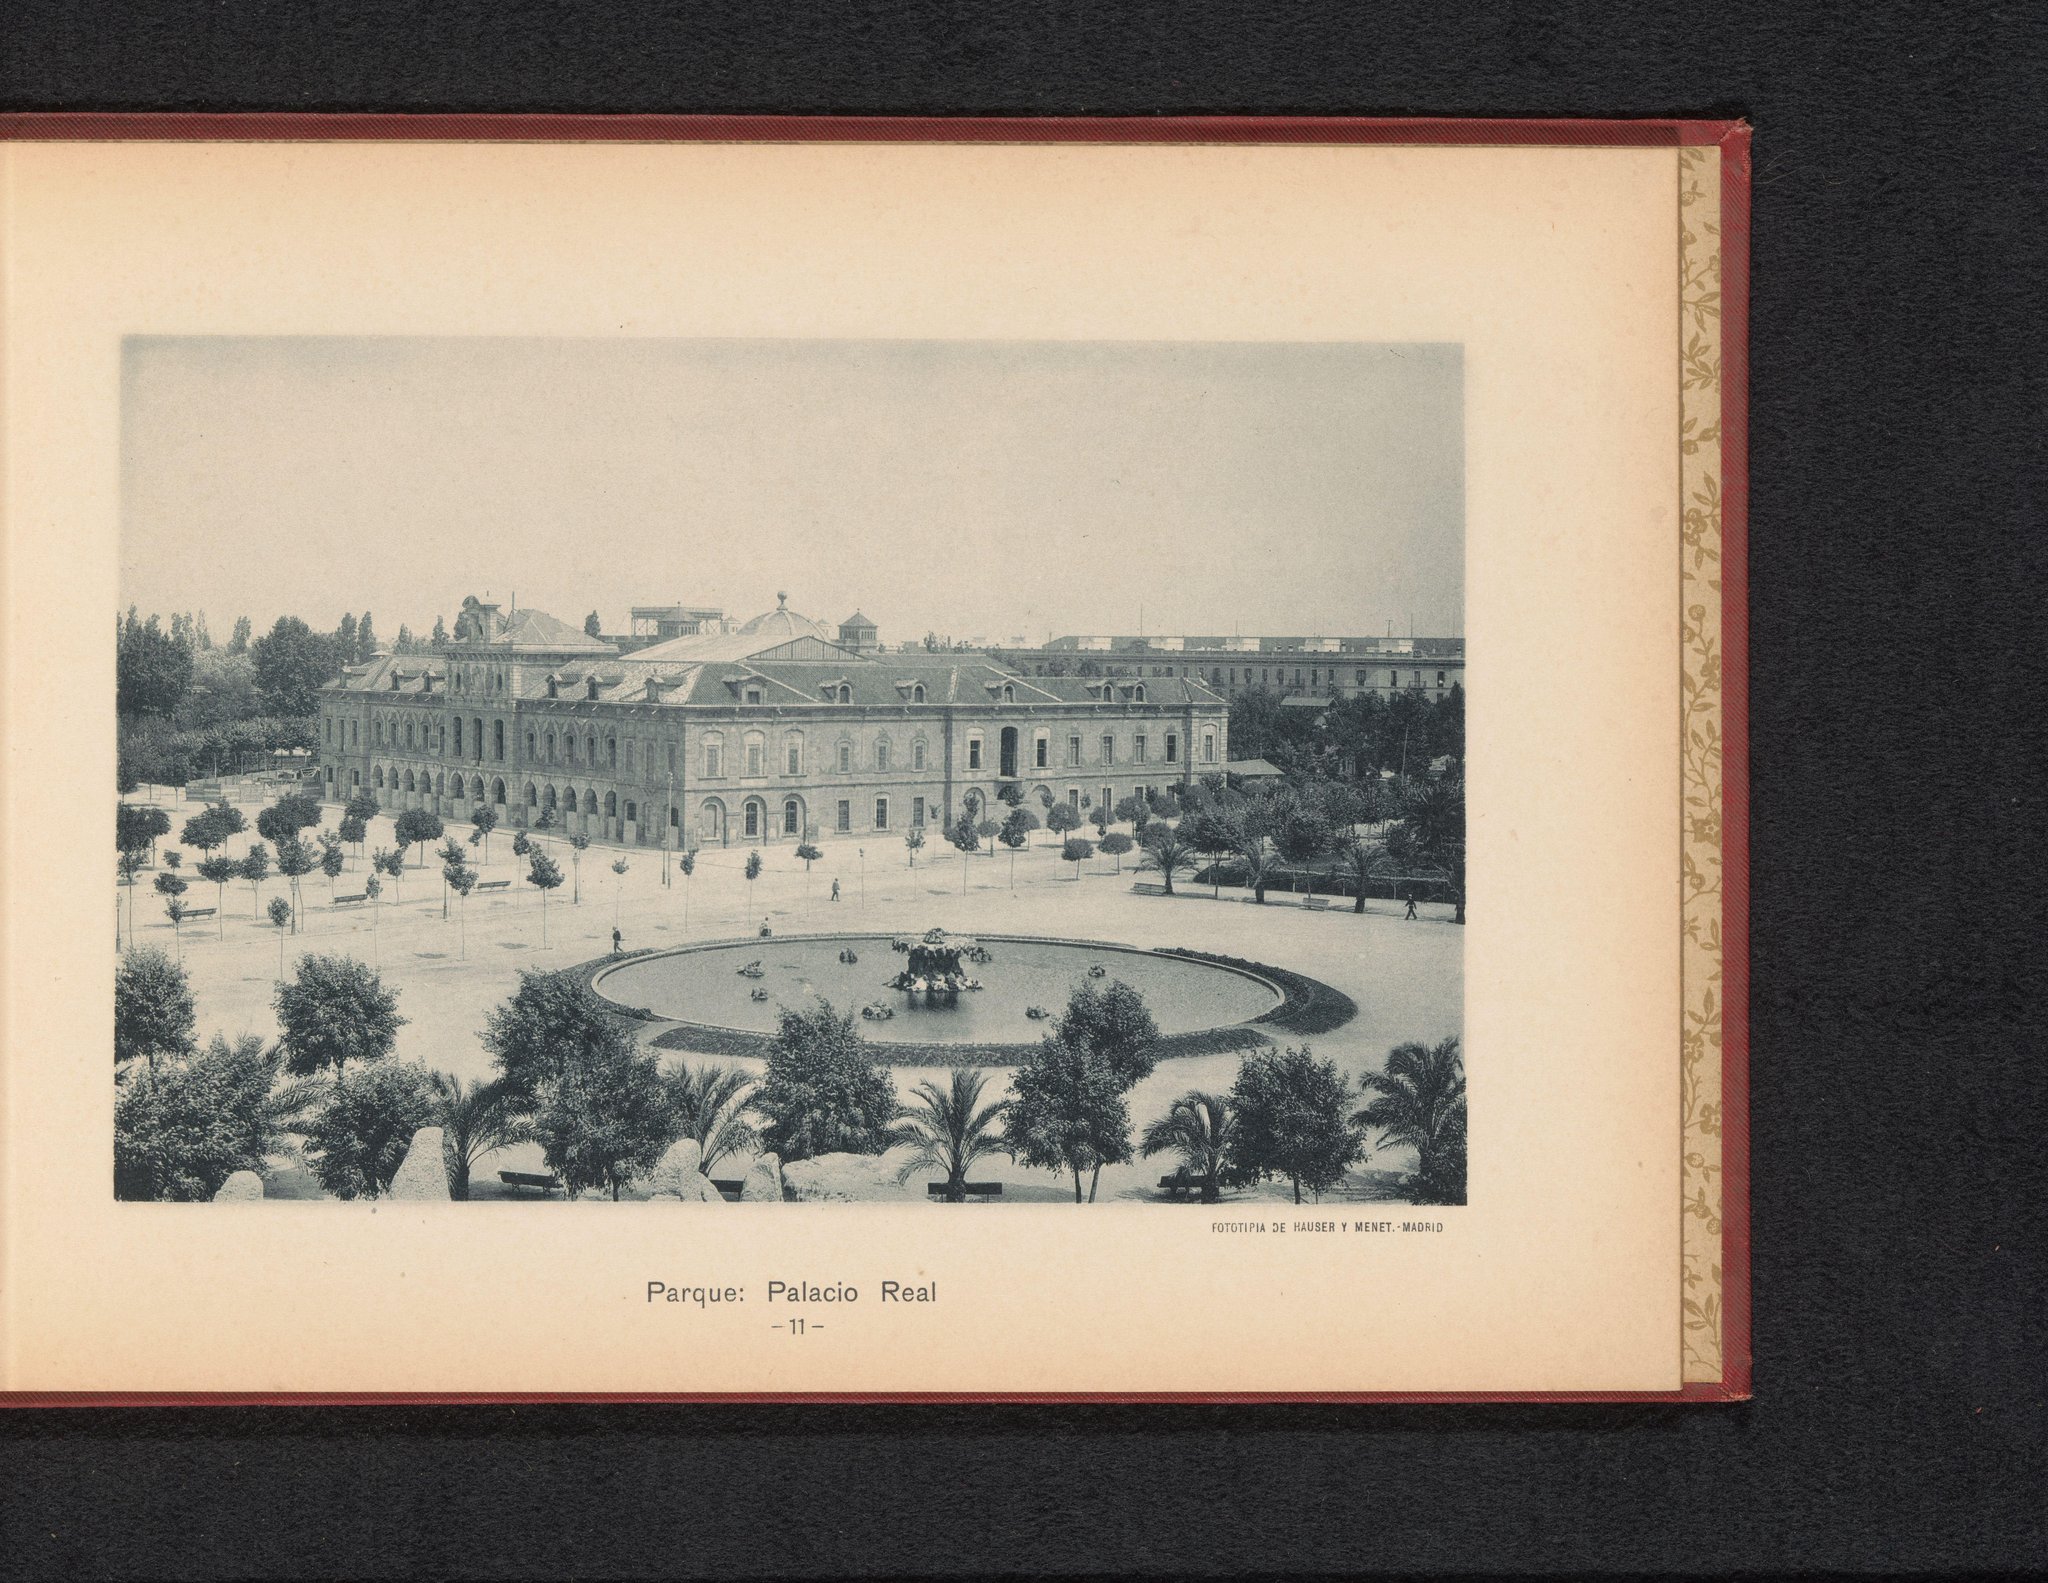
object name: page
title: Parque: Palacio Real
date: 1880-1890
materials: paper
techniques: photograph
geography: barcelona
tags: palace, ornamental fountain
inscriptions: number: ‘-11-’